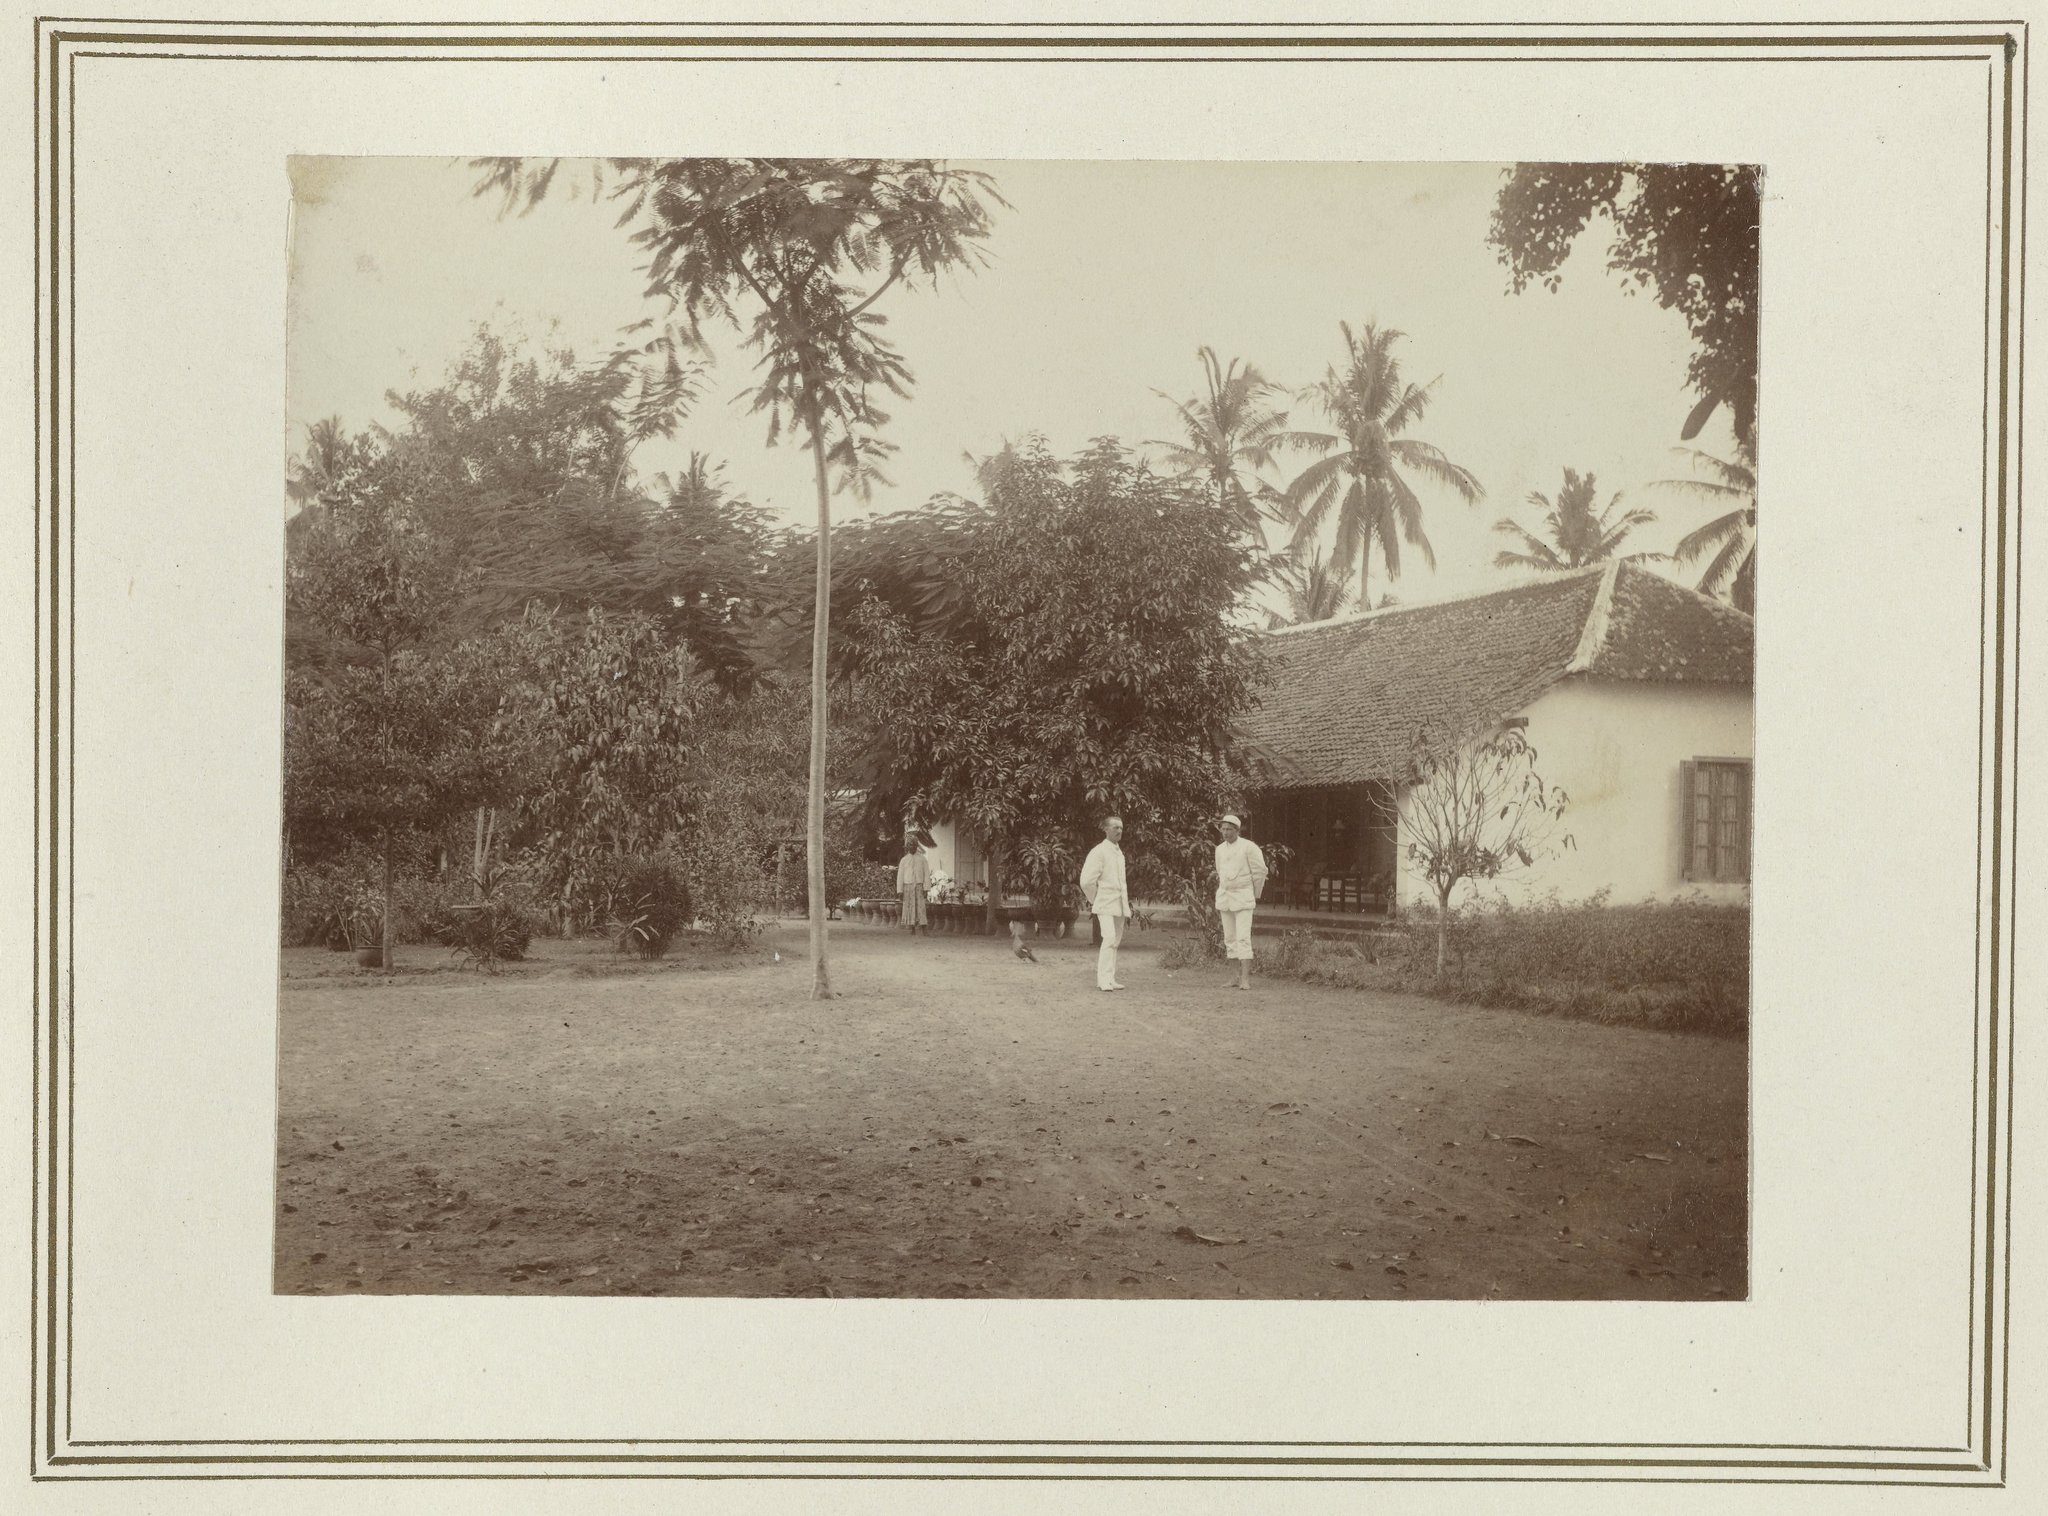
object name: photograph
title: Twee mannen voor een huis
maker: kassian céphas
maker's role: fotograaf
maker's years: 1845-1912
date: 1886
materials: photographic support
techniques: albumen print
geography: jogjakarta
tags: the hague, villa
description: Twee Nederlandse mannen staande voor een huis, op de achtergrond een Indische bediende. Onderdeel van het fotoalbum aangeboden aan J.M. Pijnacker Hordijk bij zijn vertrek uit Jogyakarta in 1886.